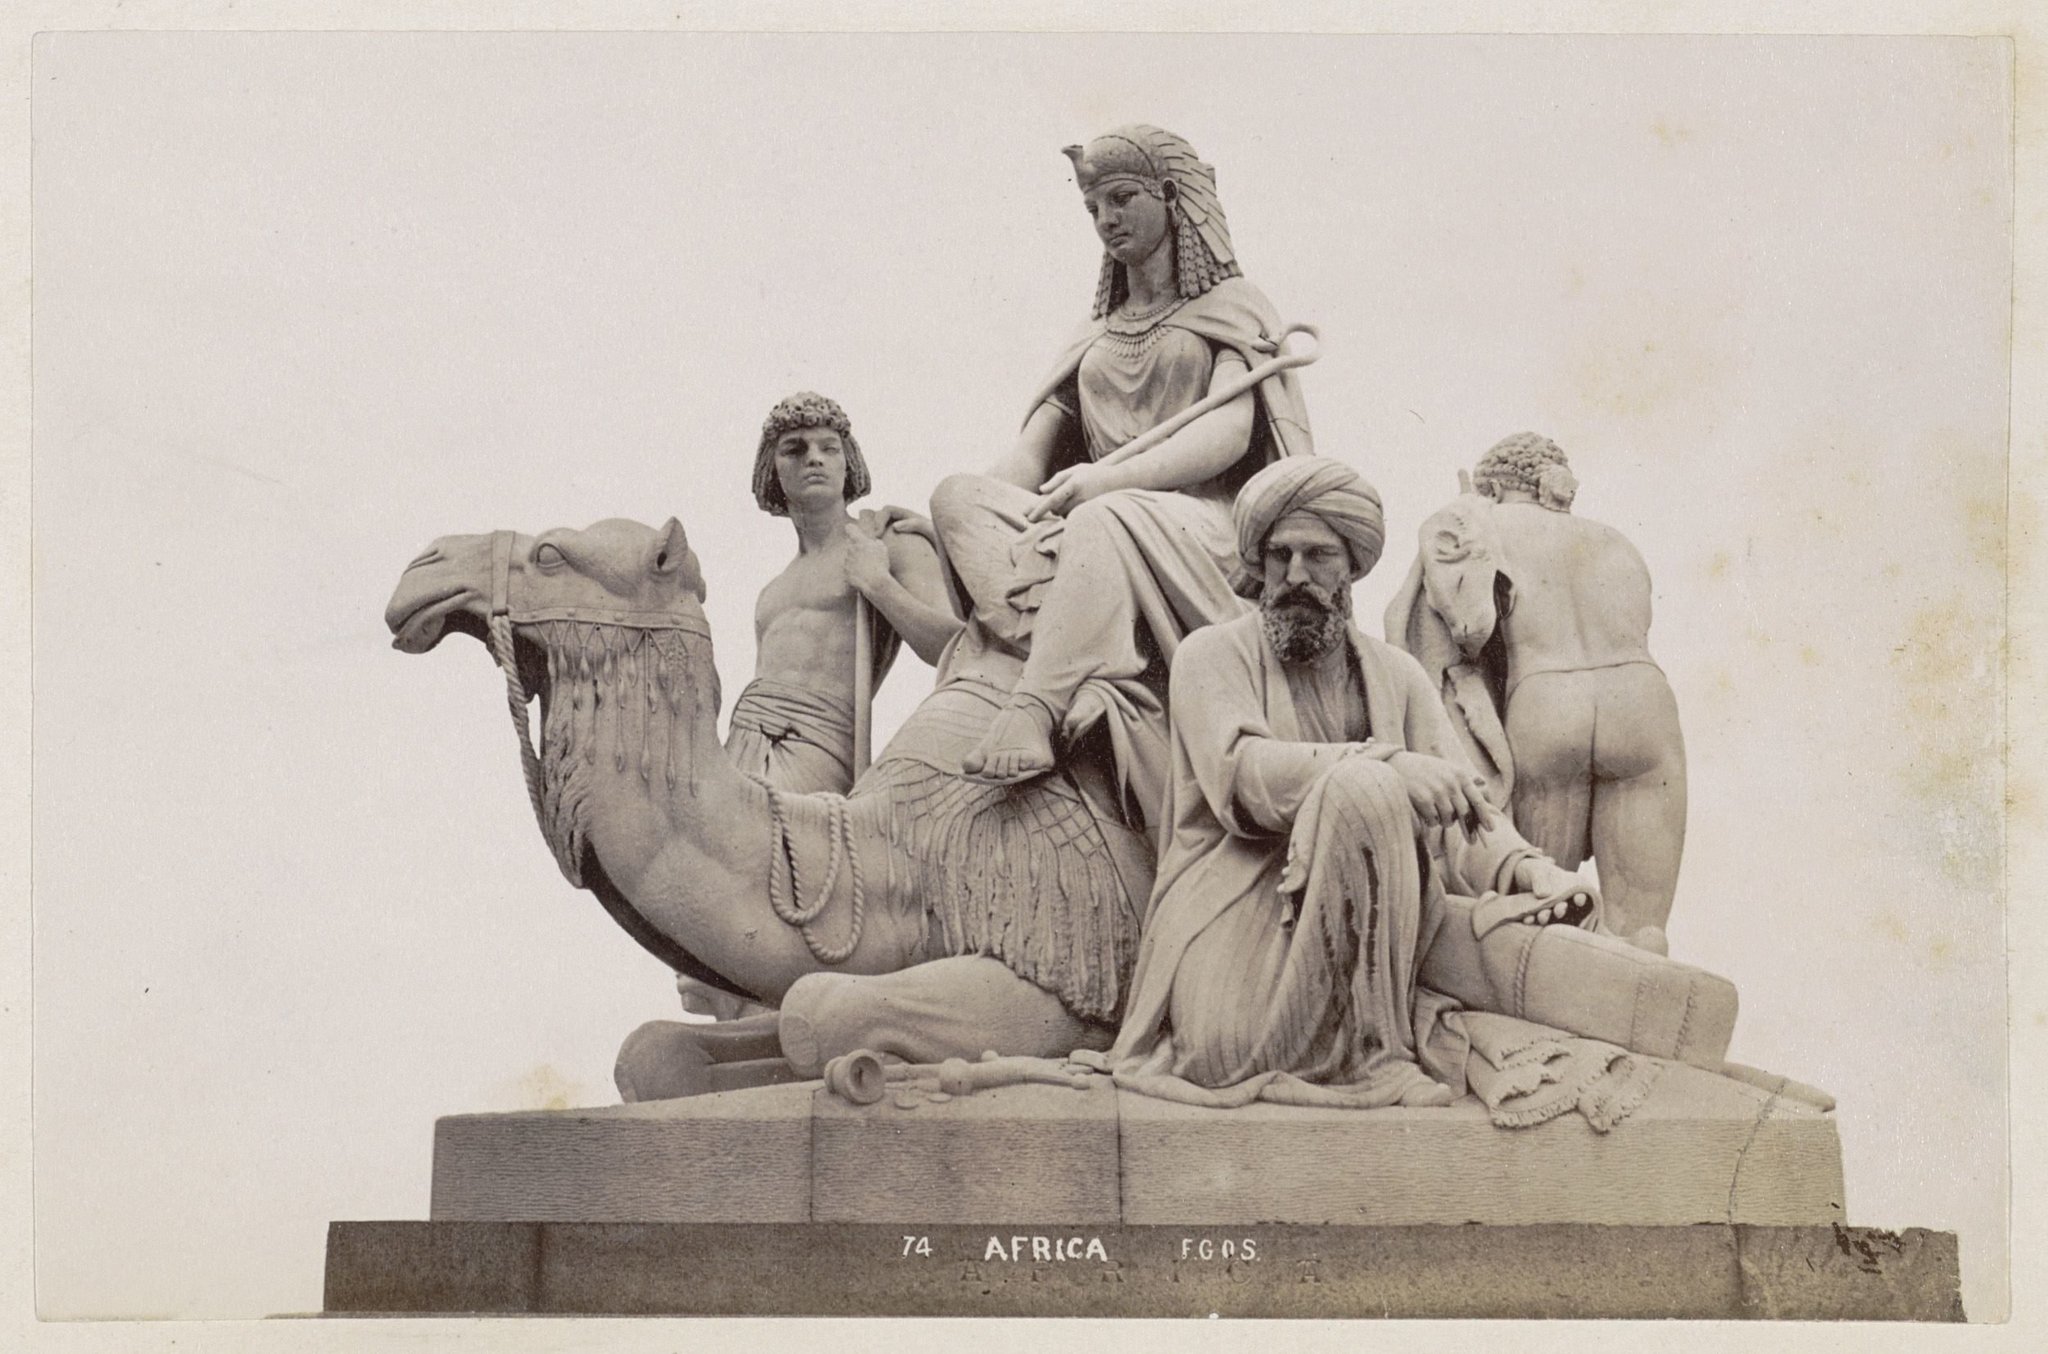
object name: photograph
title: Africa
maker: francis godolphin osbourne stuart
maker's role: fotograaf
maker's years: 1843-1923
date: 1878-1890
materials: photographic support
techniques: albumen print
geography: london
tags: piece of sculpture, reproduction of a piece of sculpture (+ sculpture), monument, statue, london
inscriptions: negative number: ‘74’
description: Onderdeel van Reisalbum Europese steden, vermoedelijk Zweeds.